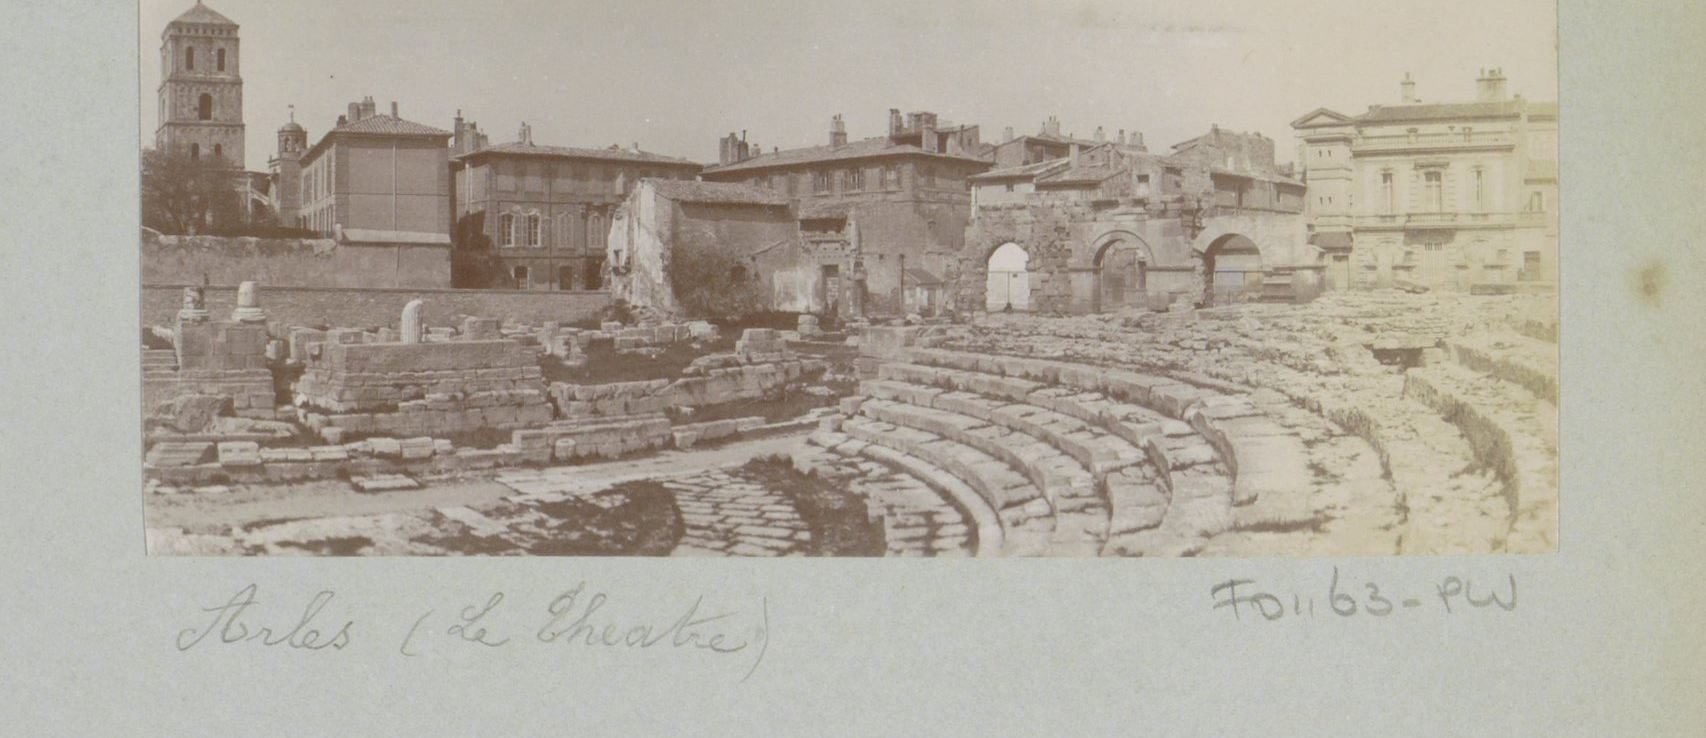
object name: photograph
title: Restanten van een Gallo-Romeins theater in Arles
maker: delizy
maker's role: manufacturer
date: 1903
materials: paper, photographic support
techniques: gelatin silver print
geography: saint-trophime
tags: ruin of a building ~ architecture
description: Onderdeel van Fotoalbum van een Franse amateurfotograaf met opnames van uitstapjes in Frankrijk, Spanje, België, Luxemburg en Nederland, de eerste automobielen en autoraces.